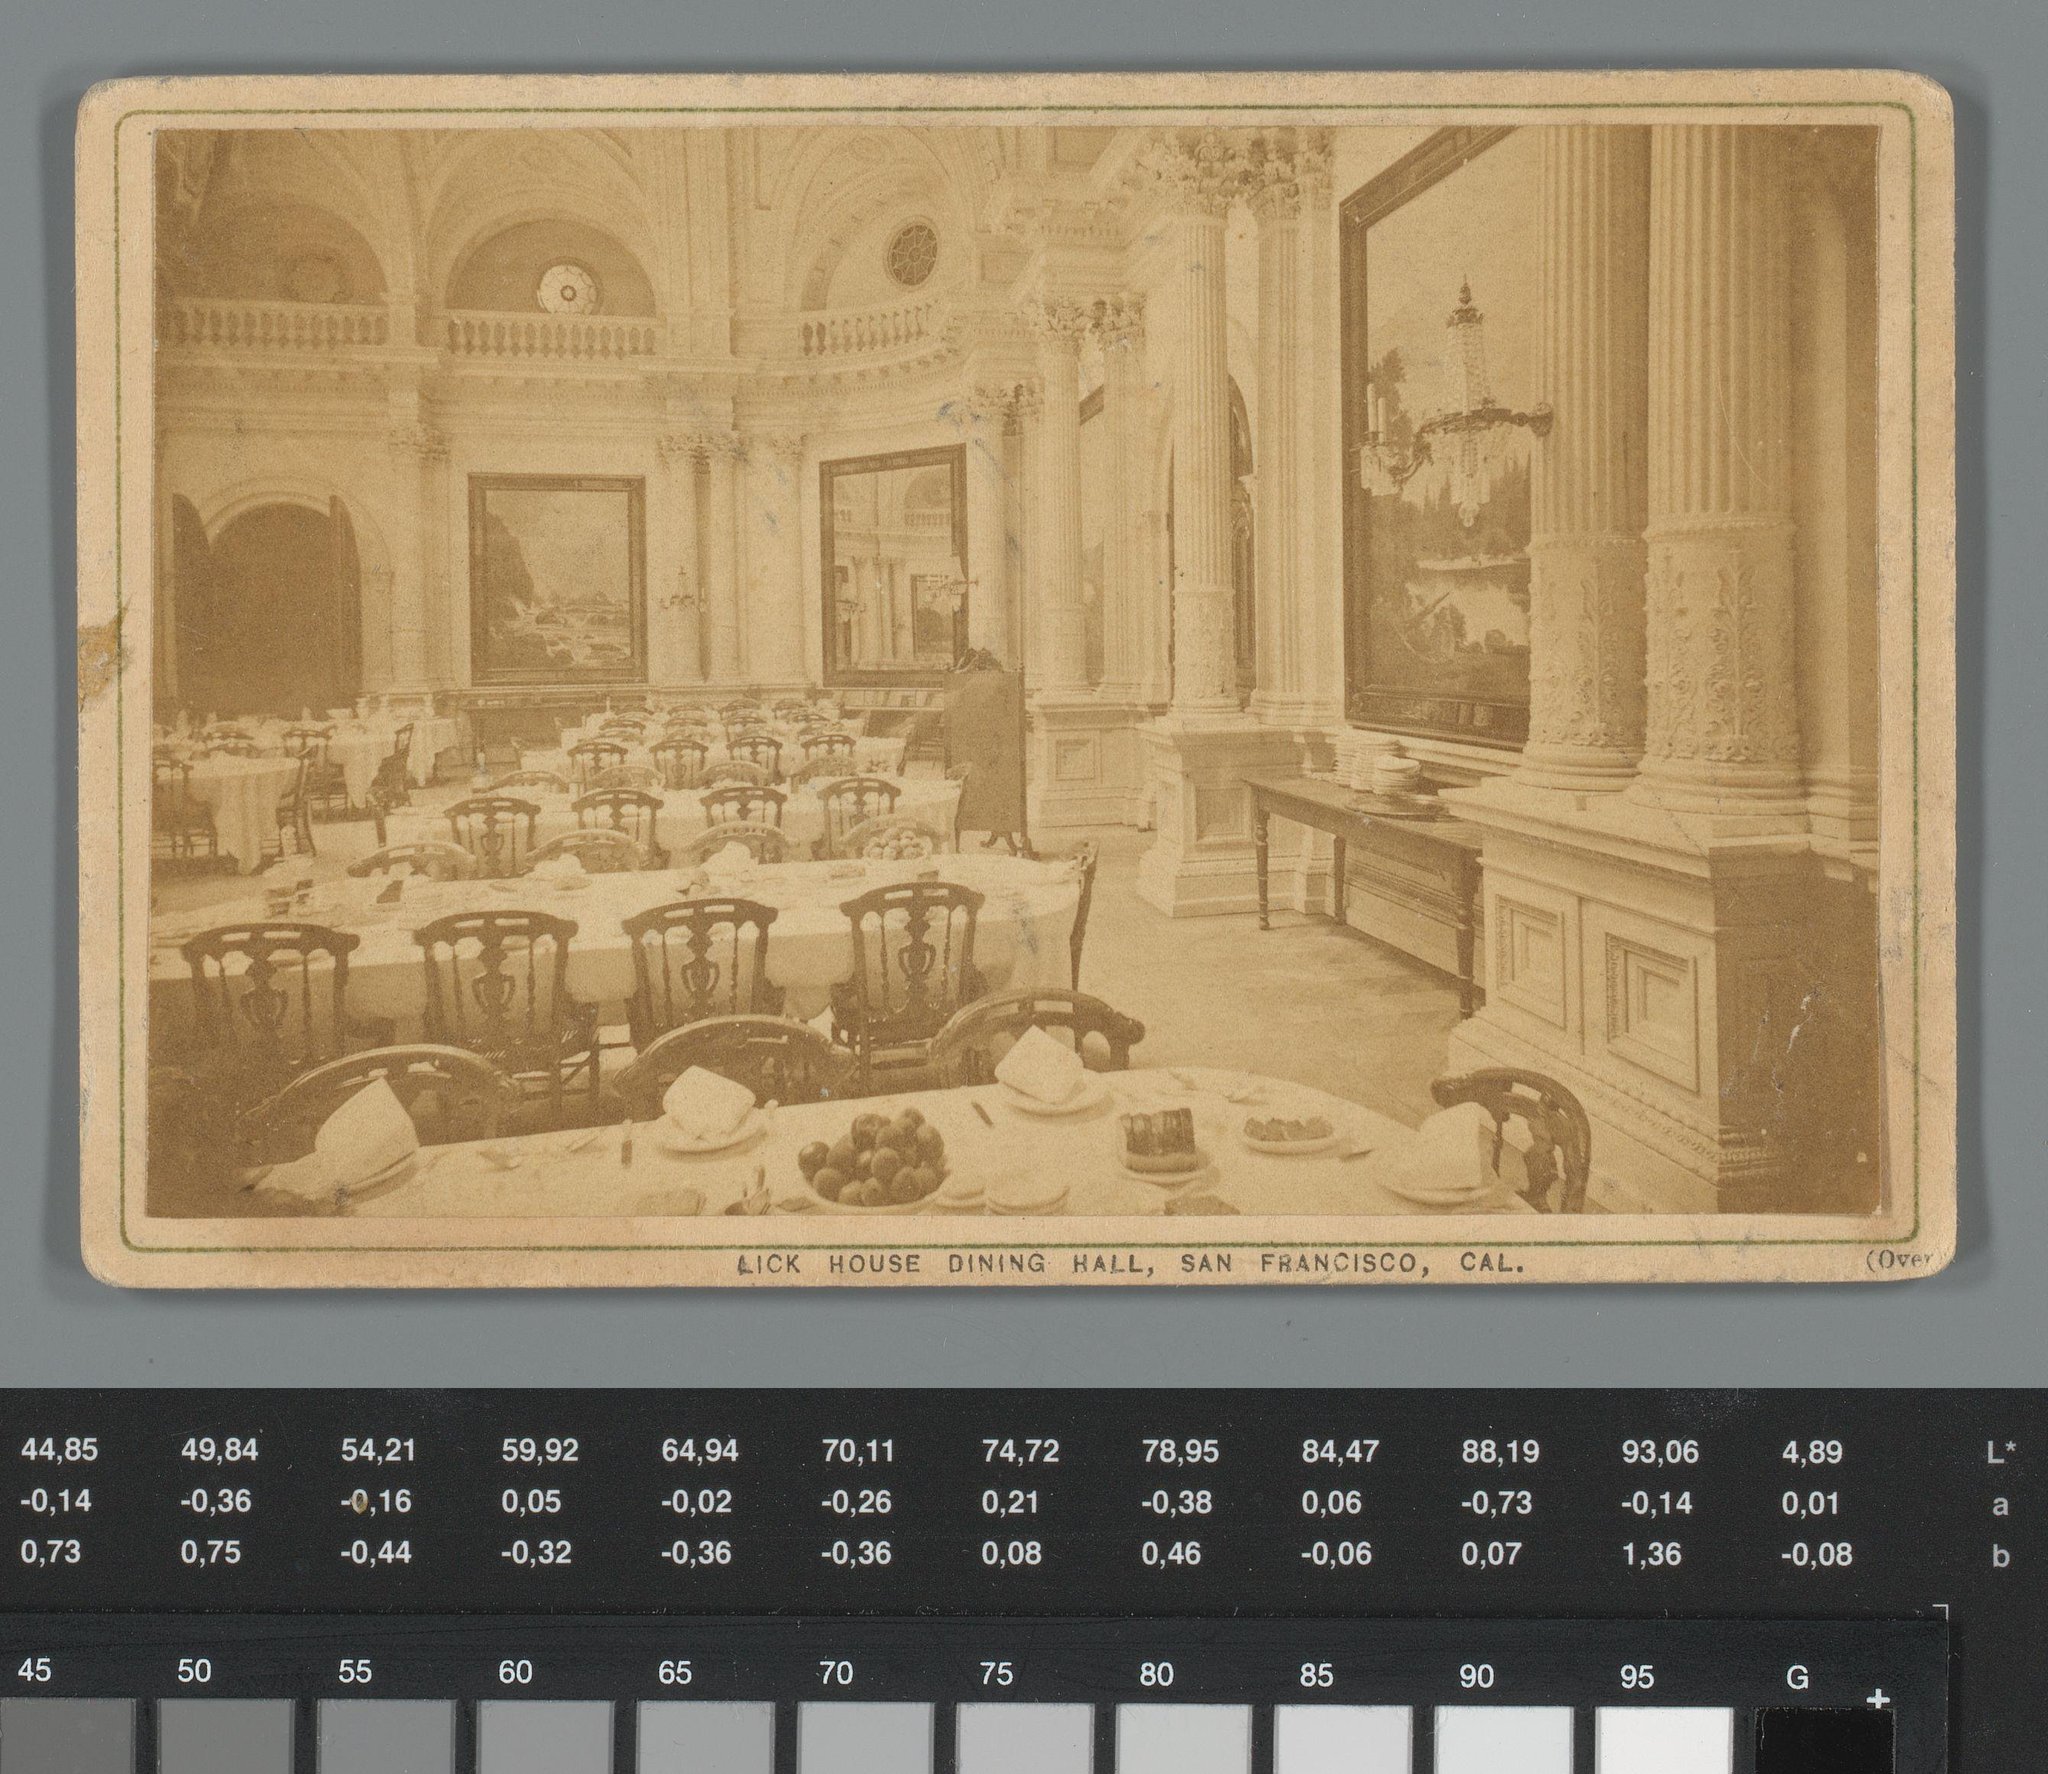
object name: photograph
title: Gezicht op de eetzaal in Lick House, San Francisco, Californië, met reclame voor diner aldaar en Watkins' Yosemite Art Gallery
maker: Anonymous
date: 1872-1915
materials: cardboard, photographic support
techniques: albumen print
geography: san francisco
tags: advertising, dining-room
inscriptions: inscription: ‘(...)/ American Opinion: Springfield Repb. Ap'l. 19, 1872./ (...)’